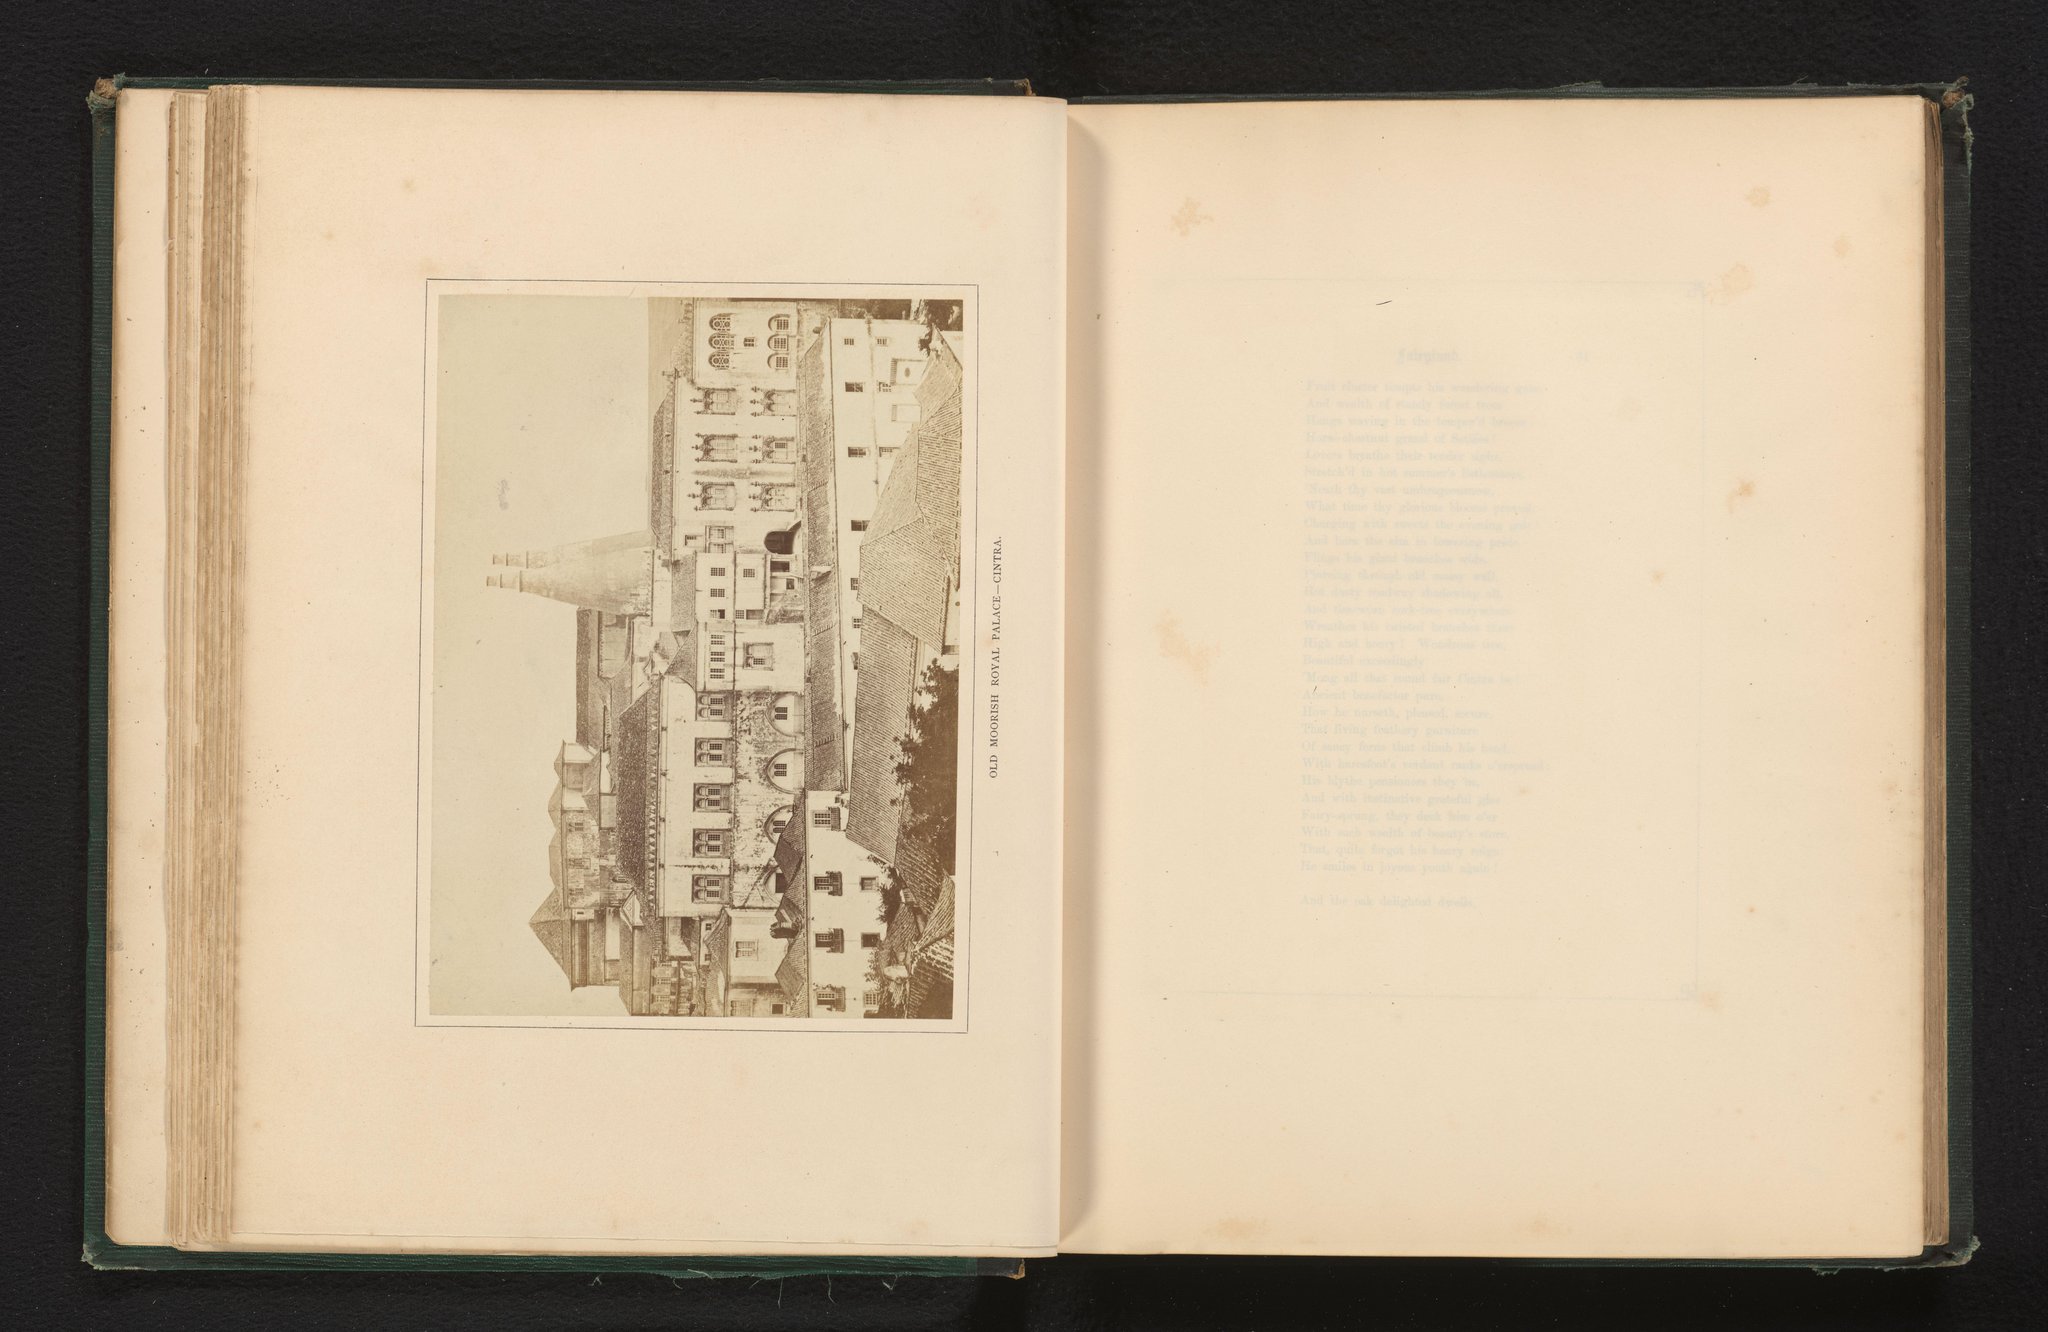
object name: page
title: Gezicht op het Paleis van Sintra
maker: Anonymous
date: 1865-1870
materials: paper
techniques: albumen print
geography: sintra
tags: palace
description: Foto op tweede ongenummerde pagina na pagina 30.